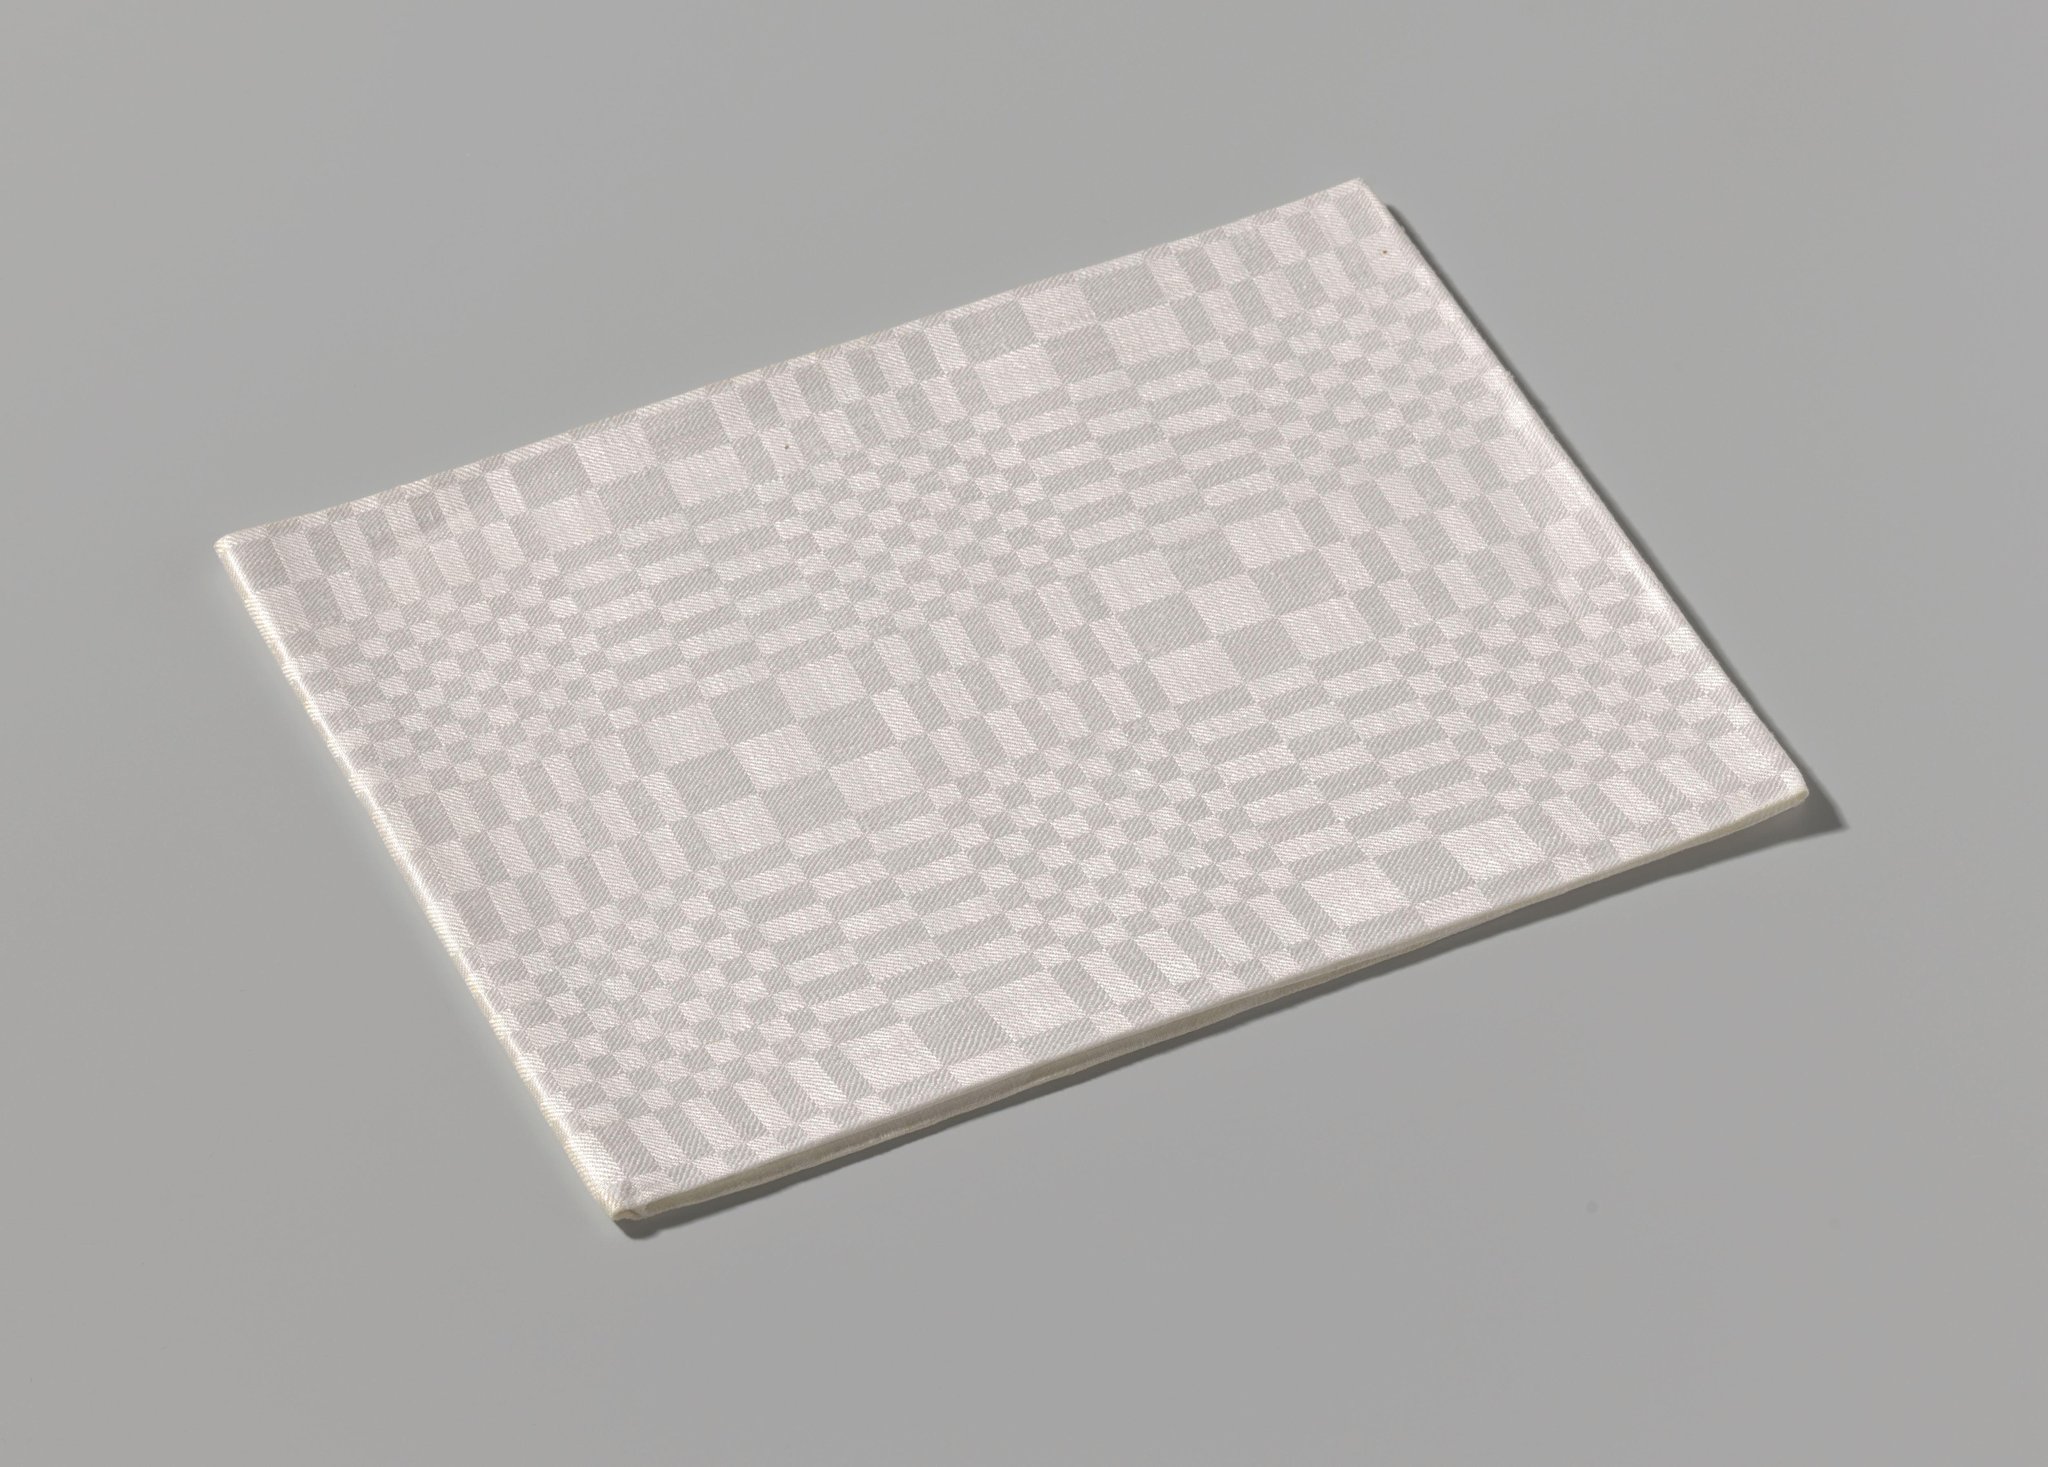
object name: napkin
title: Servet van linnen met pellenpatroon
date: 1784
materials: linen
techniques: twill, peeled fabric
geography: northern netherlands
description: wit linnen servet met pellen patroon, z.g. Engelse garderobe, merk WS 104 en 1784